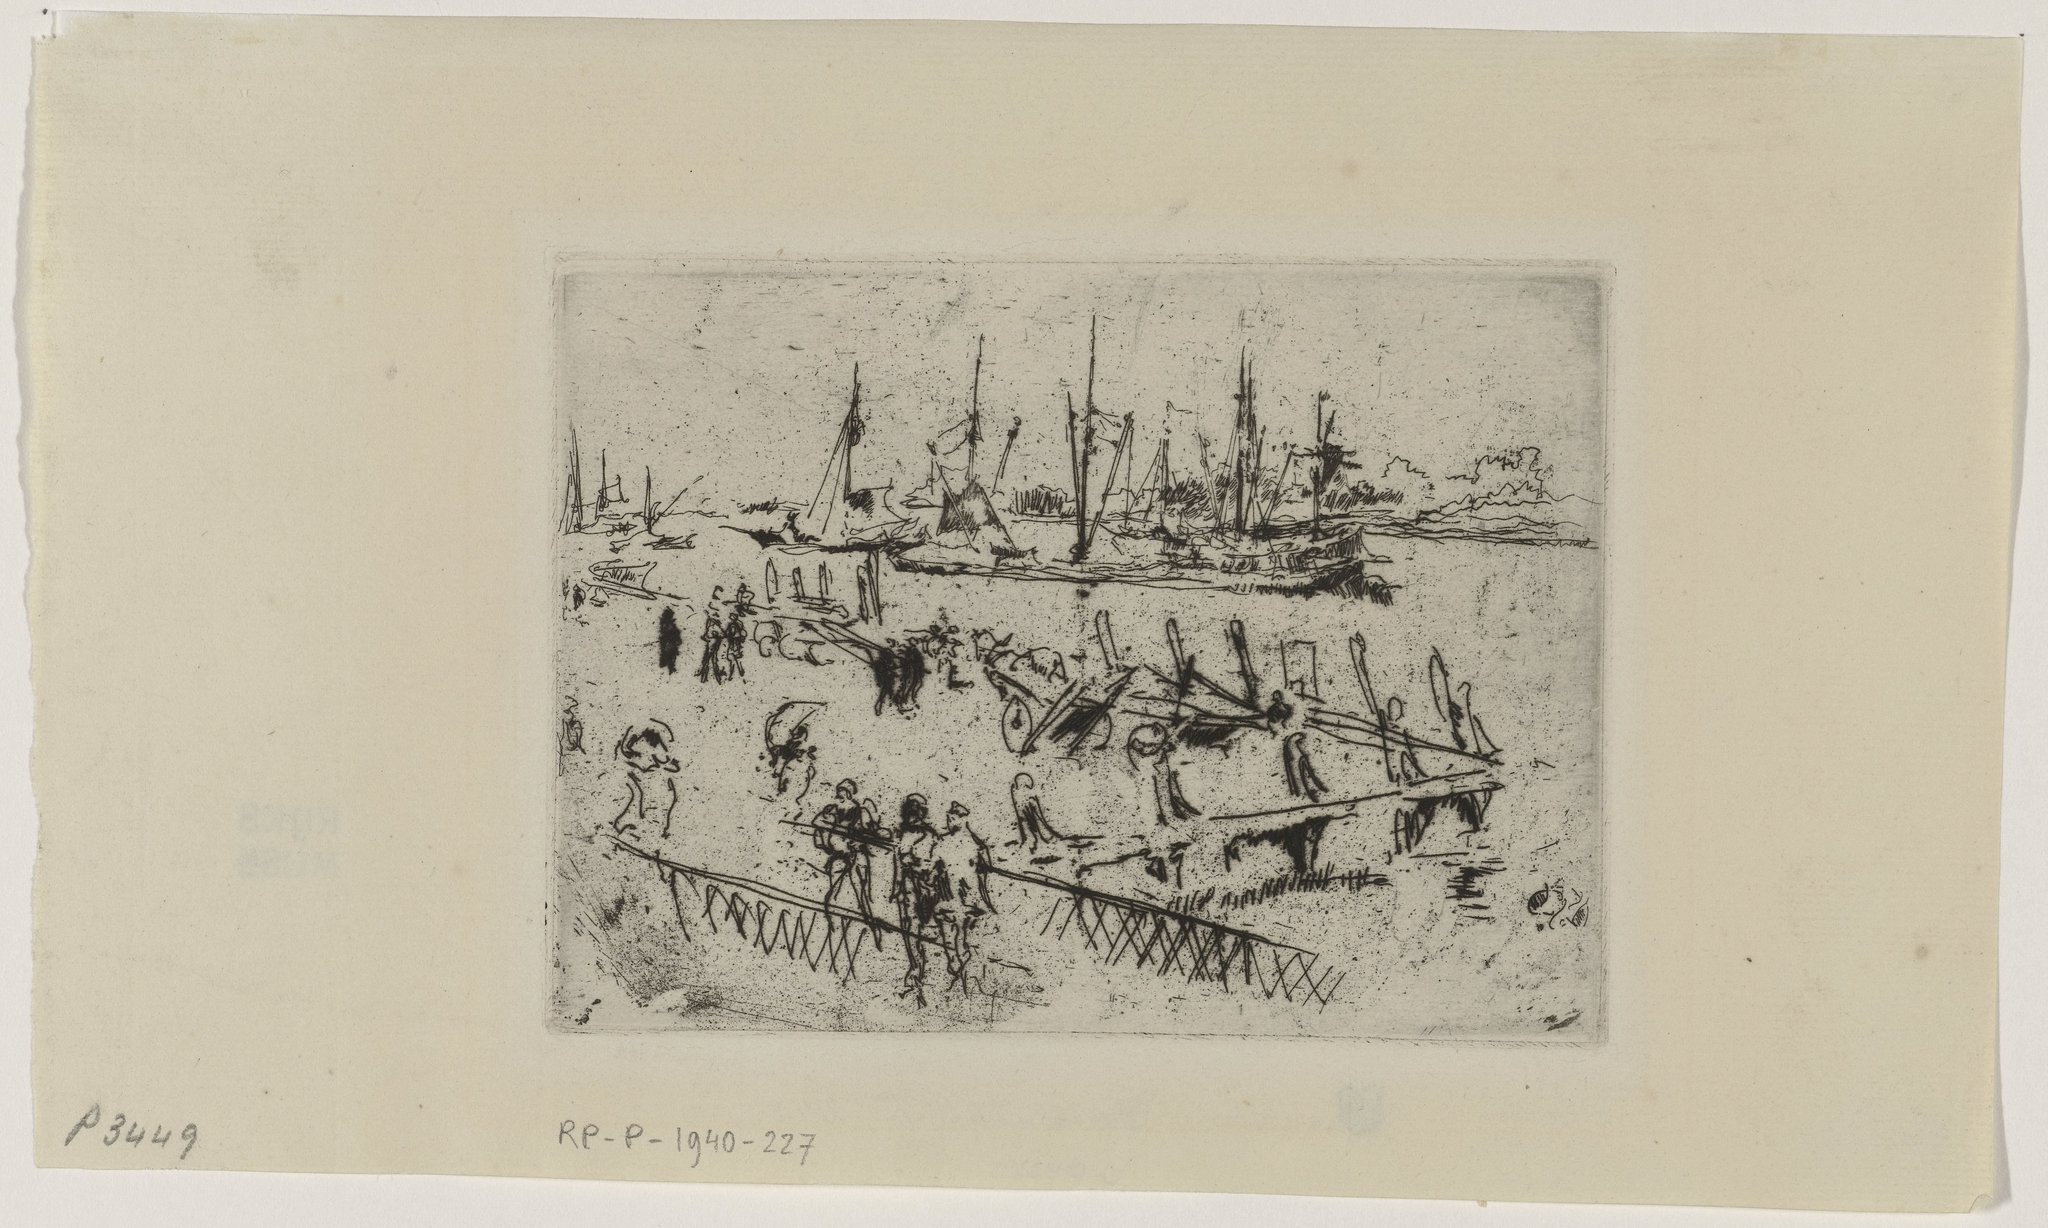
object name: print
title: Little Dordrecht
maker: james abbott mcneill whistler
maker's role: painter, print maker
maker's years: 1834-1903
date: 1884-1887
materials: paper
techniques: drypoint, etching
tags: quay, dordrecht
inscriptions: collector's mark: Lugt 2760, collector's mark: Lugt 2166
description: De Merwekade en op de voorgrond de zogenaamde Kippenbrug. Gezicht op het Papendrechtsche Veer te Dordrecht.